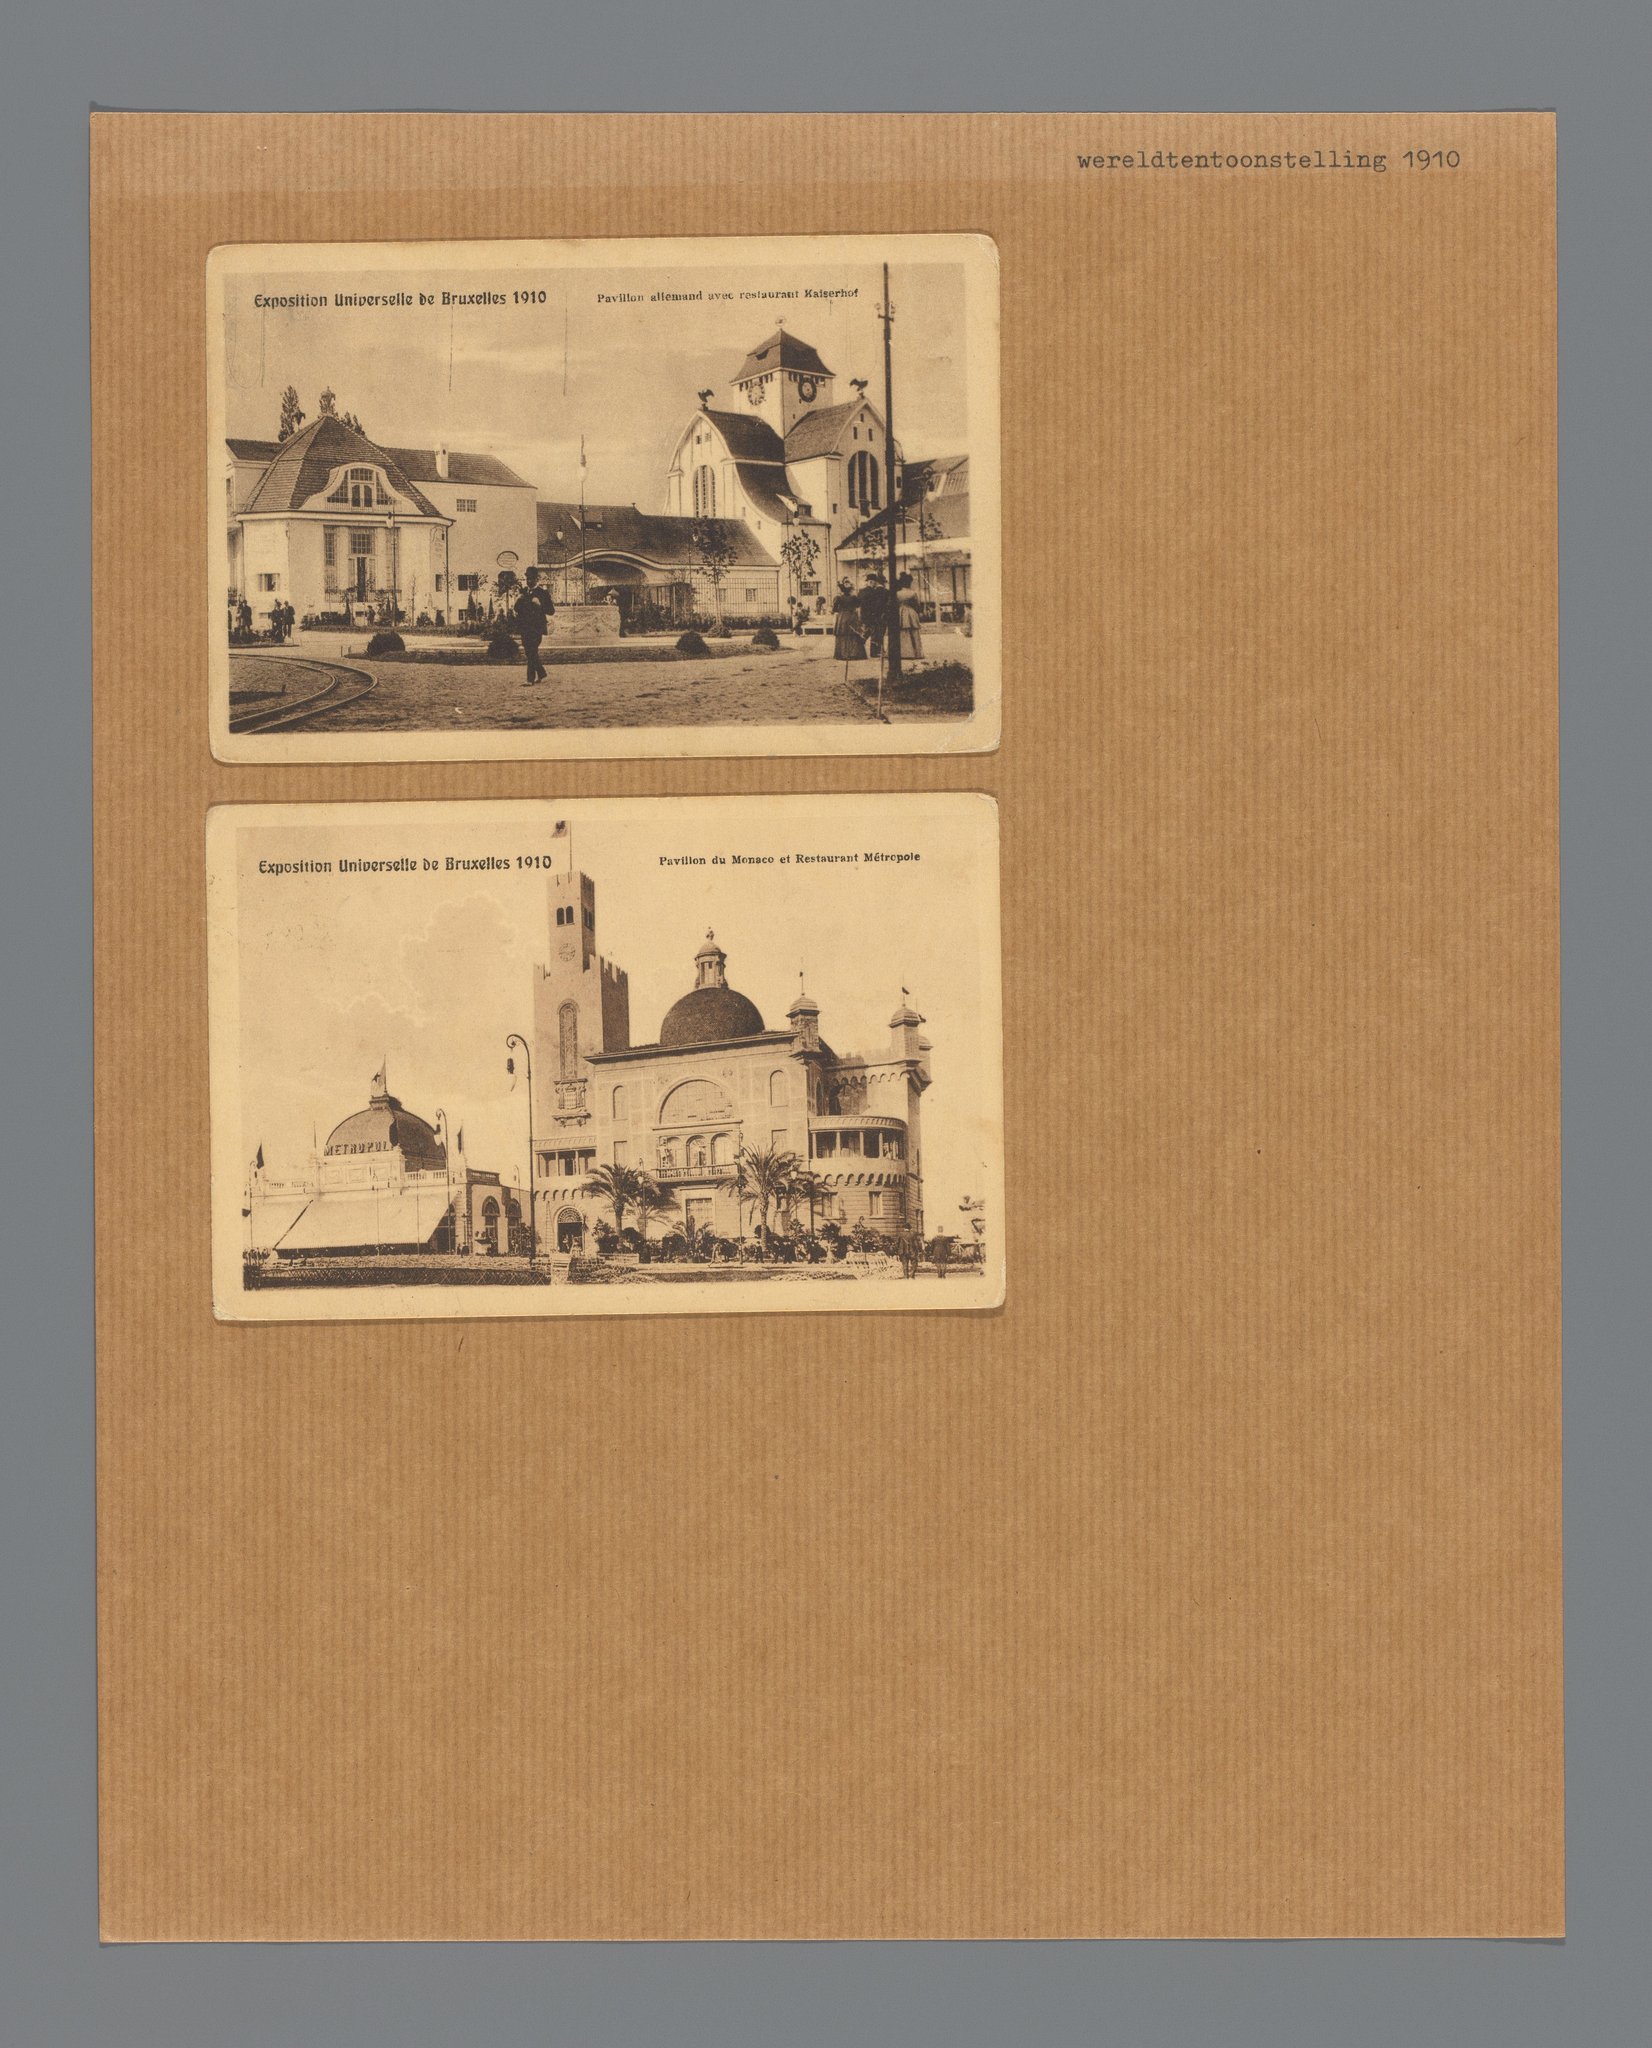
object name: photograph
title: Wereldtentoonstelling Brussels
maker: Anonymous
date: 1910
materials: photographic support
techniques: photograph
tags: brussels